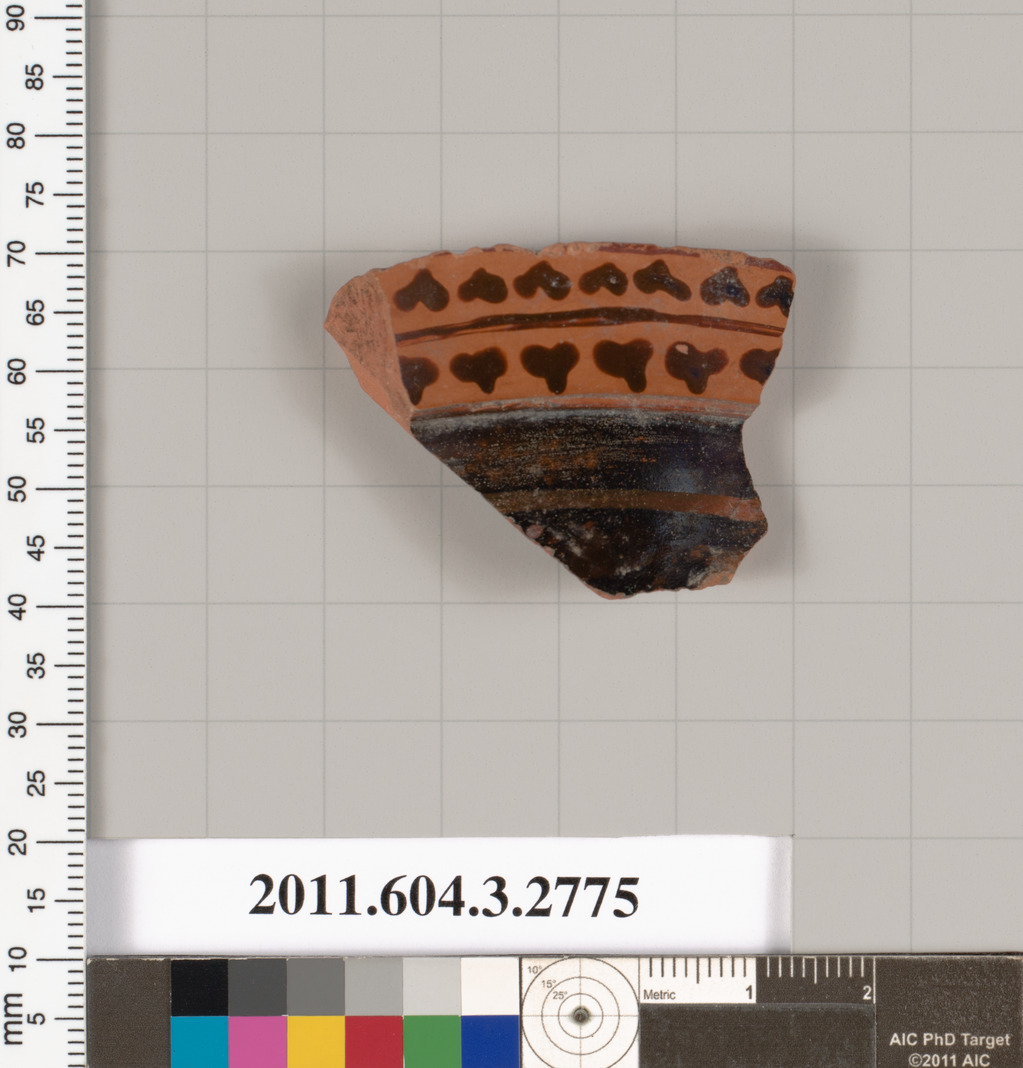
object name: olpe fragment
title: Terracotta fragment of an olpe (jug)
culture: greek, attic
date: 530-520 BCE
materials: terracotta